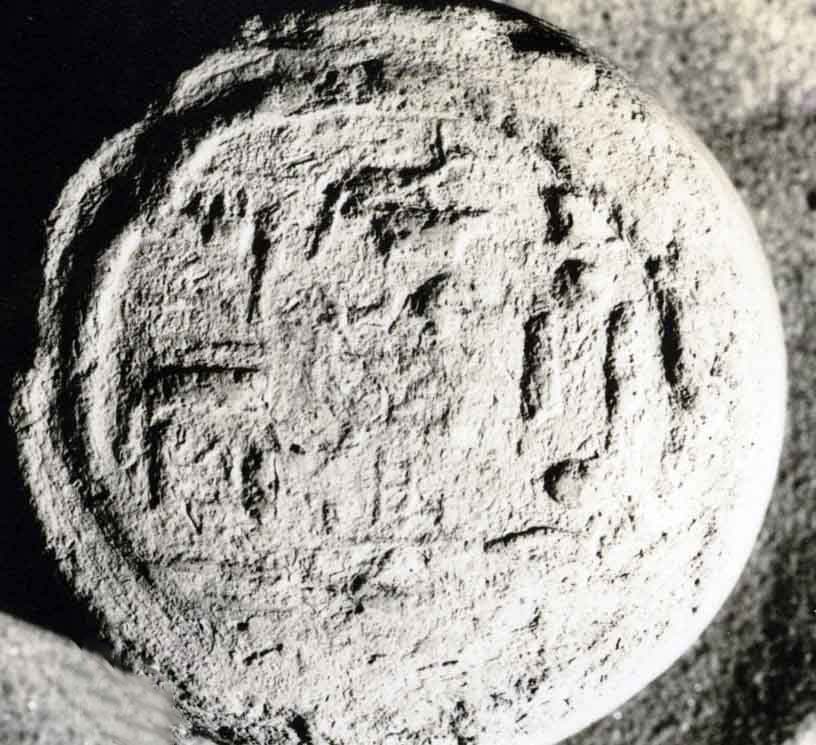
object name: cone, seshi, circular impression, overseer, ship, amun, anubis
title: Funerary Cone of the Overseer of the Ships of Amun Seshi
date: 1550-1295 BCE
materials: pottery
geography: egypt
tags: hieroglyphs